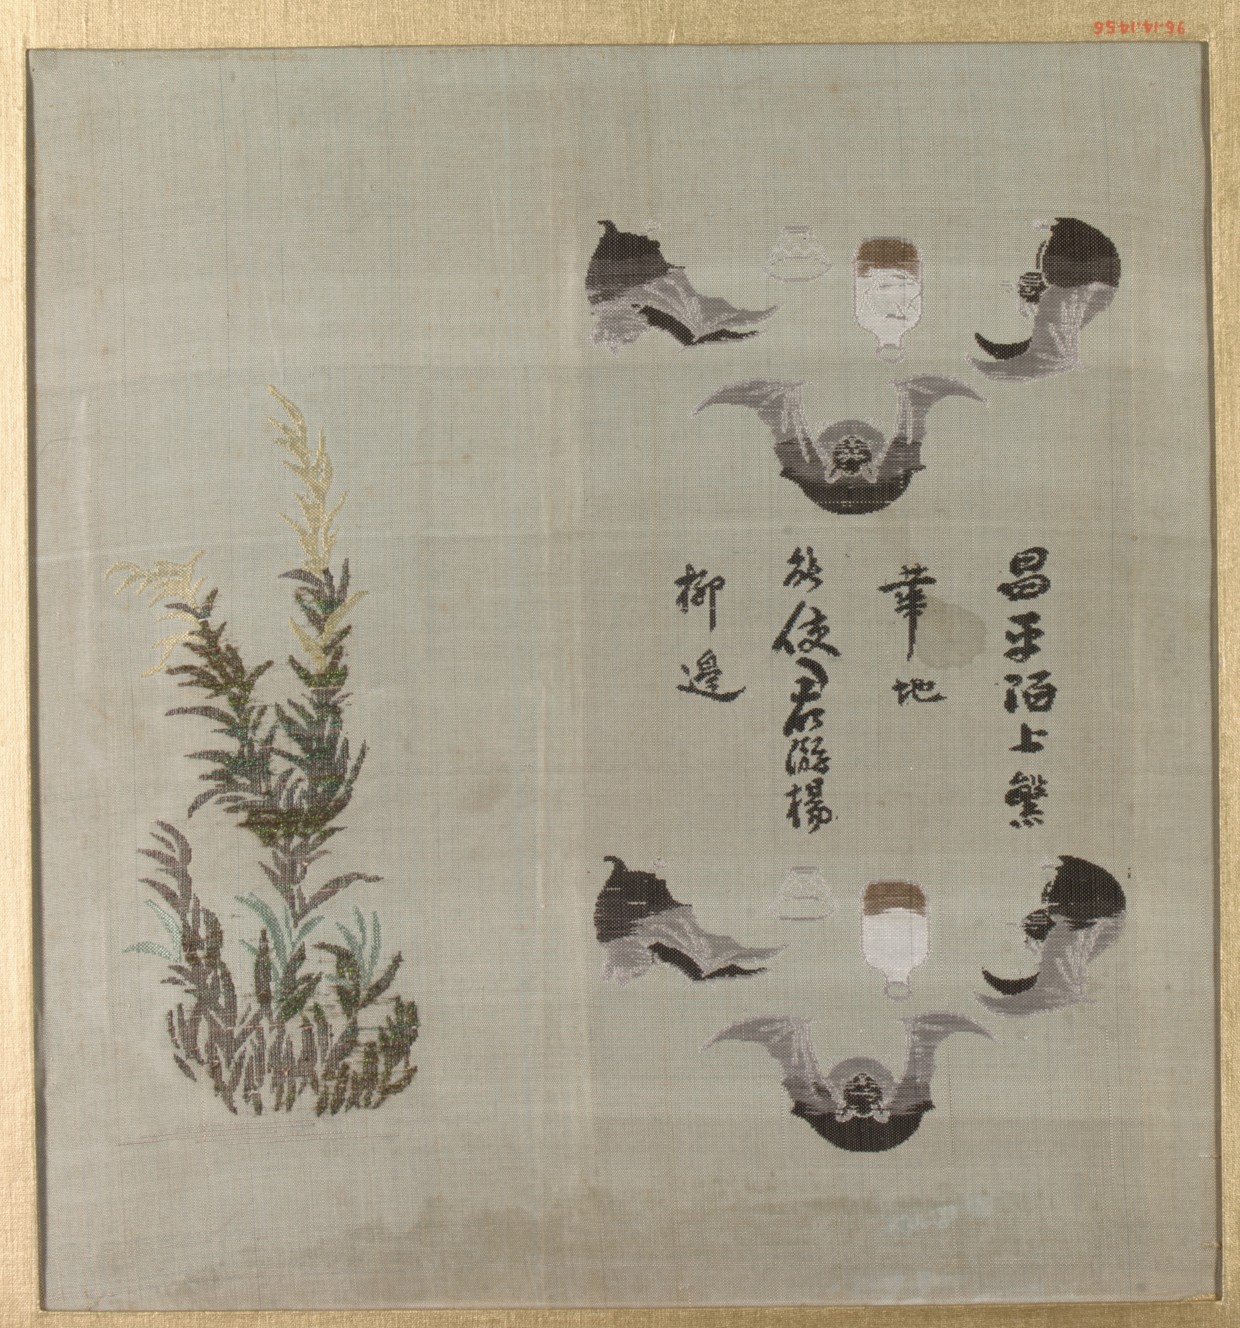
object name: piece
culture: japanese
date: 1701-1900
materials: silk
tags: bats,plants